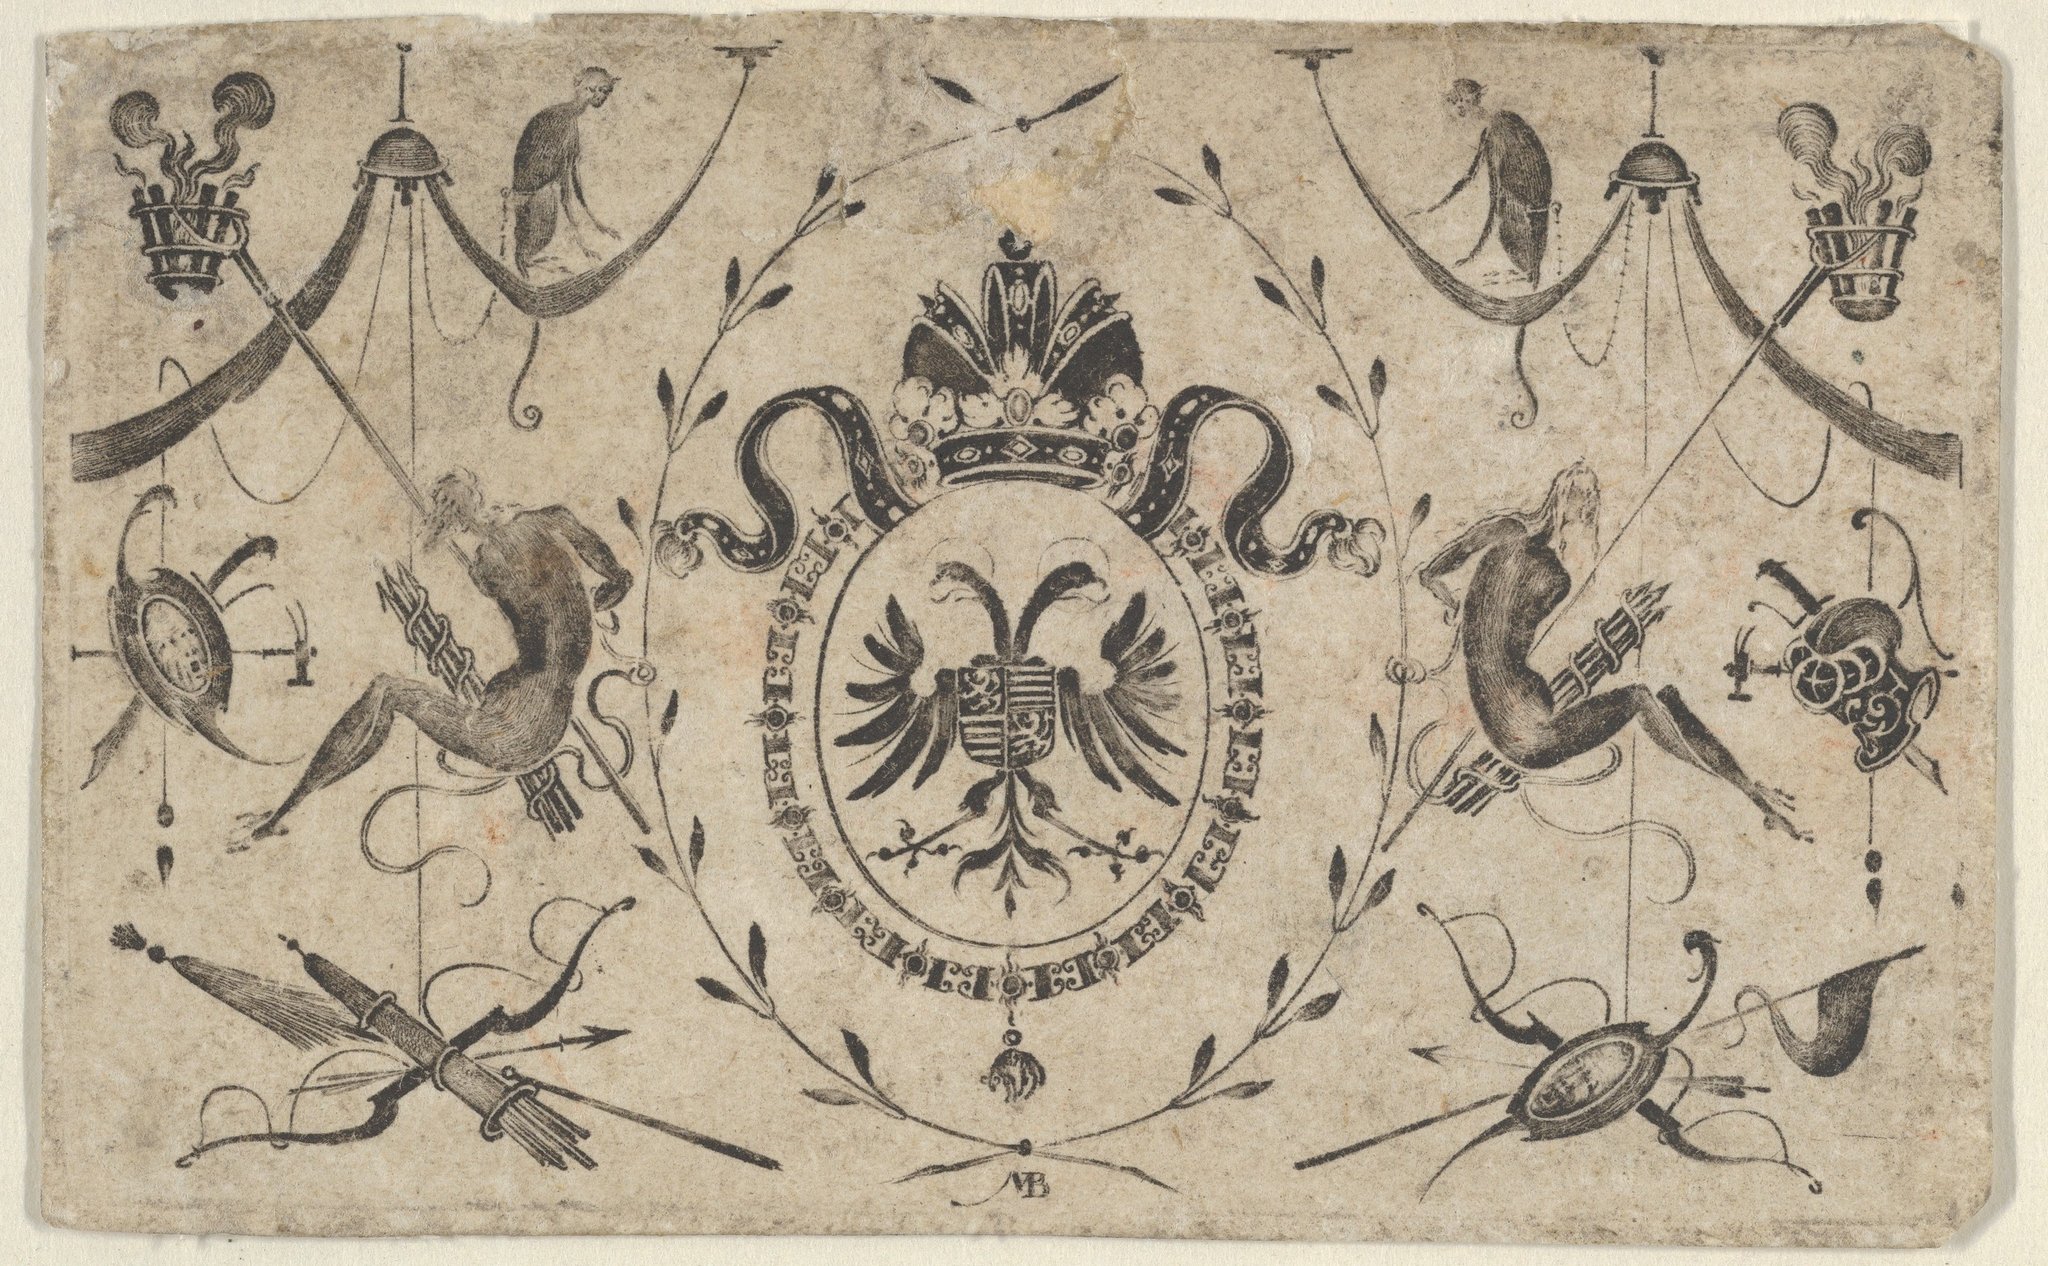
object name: print ornament architecture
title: Blackwork Design for Goldsmithwork with the Coat of Arms of a Bishop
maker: mathais beitler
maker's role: artist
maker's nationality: german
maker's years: 1582-1616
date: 1615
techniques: embroidery, engraving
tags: bow and arrow,coat of arms